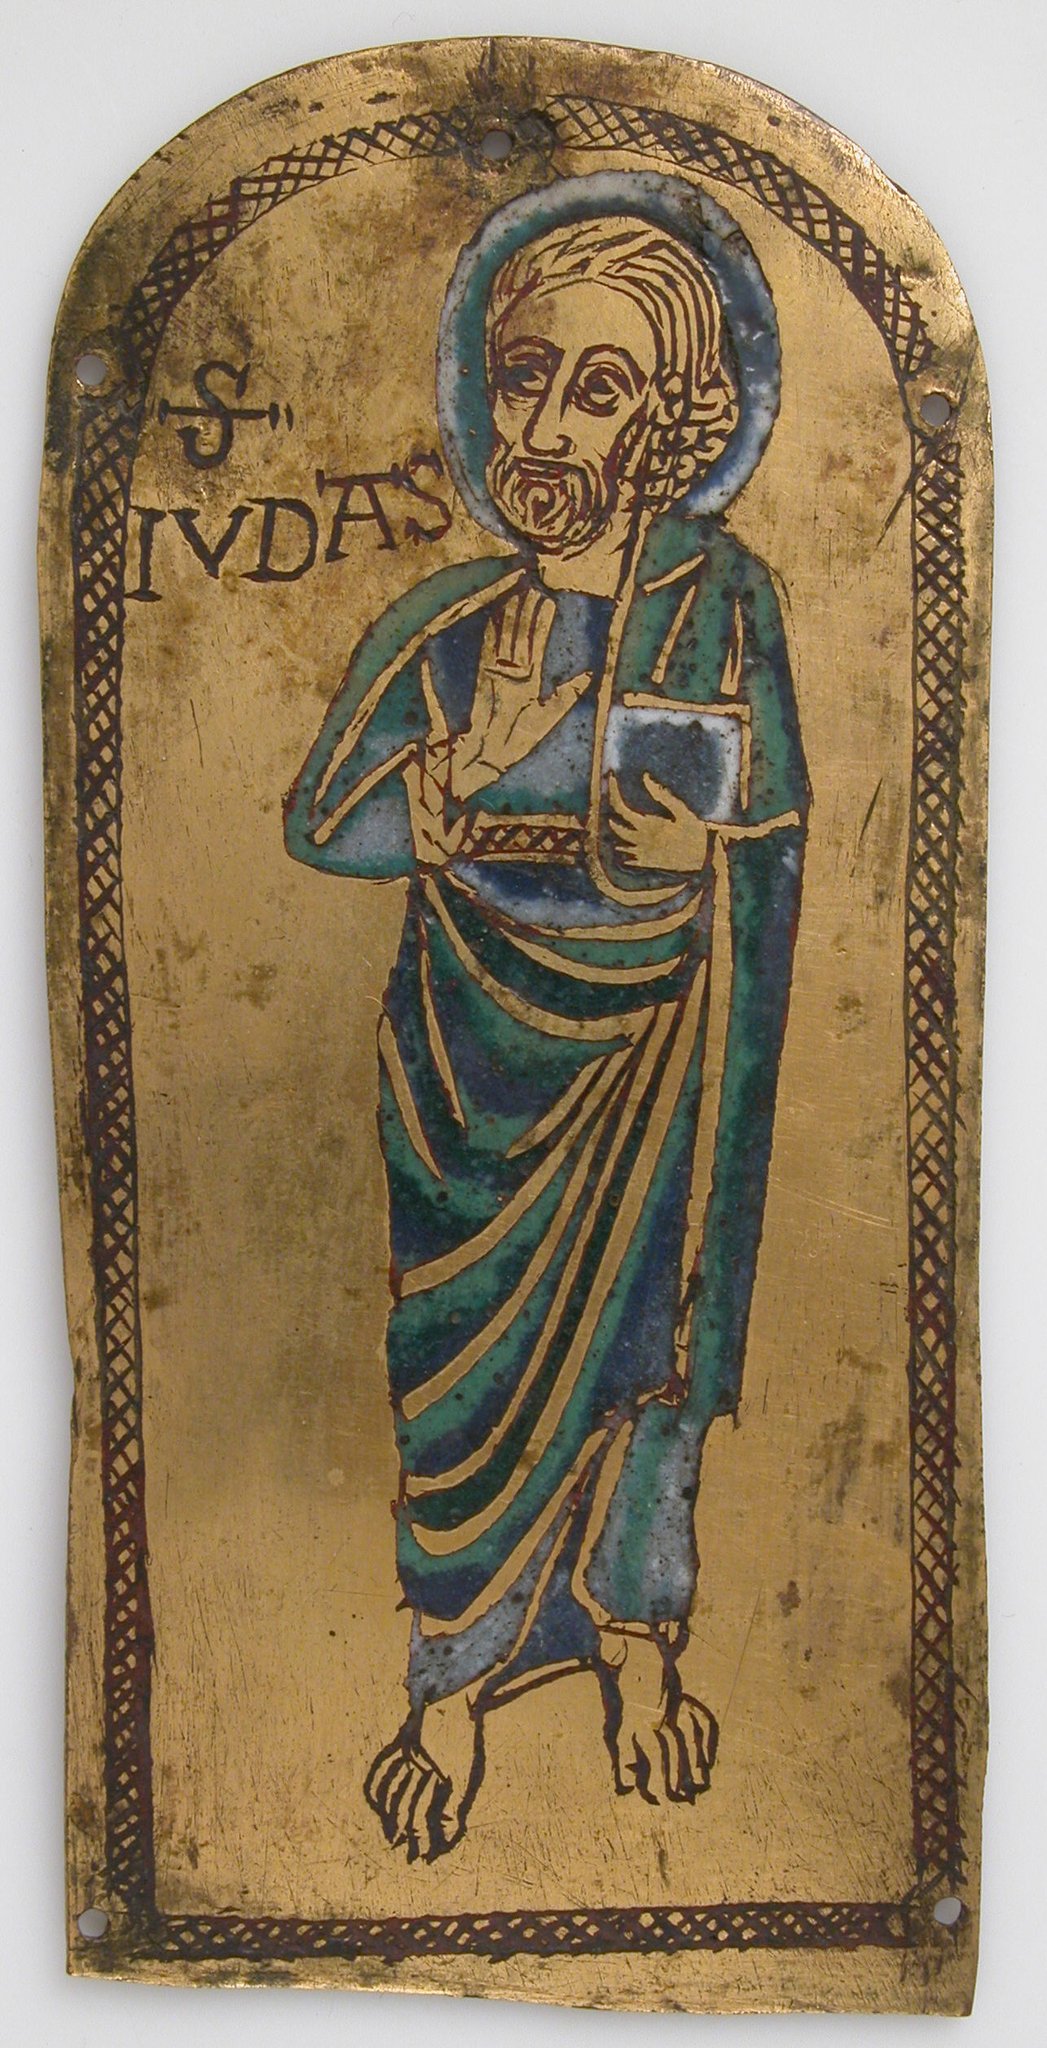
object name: plaque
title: Plaque of St. Jude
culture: german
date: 1101-1200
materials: gilt copper, enamel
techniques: enamel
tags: saints